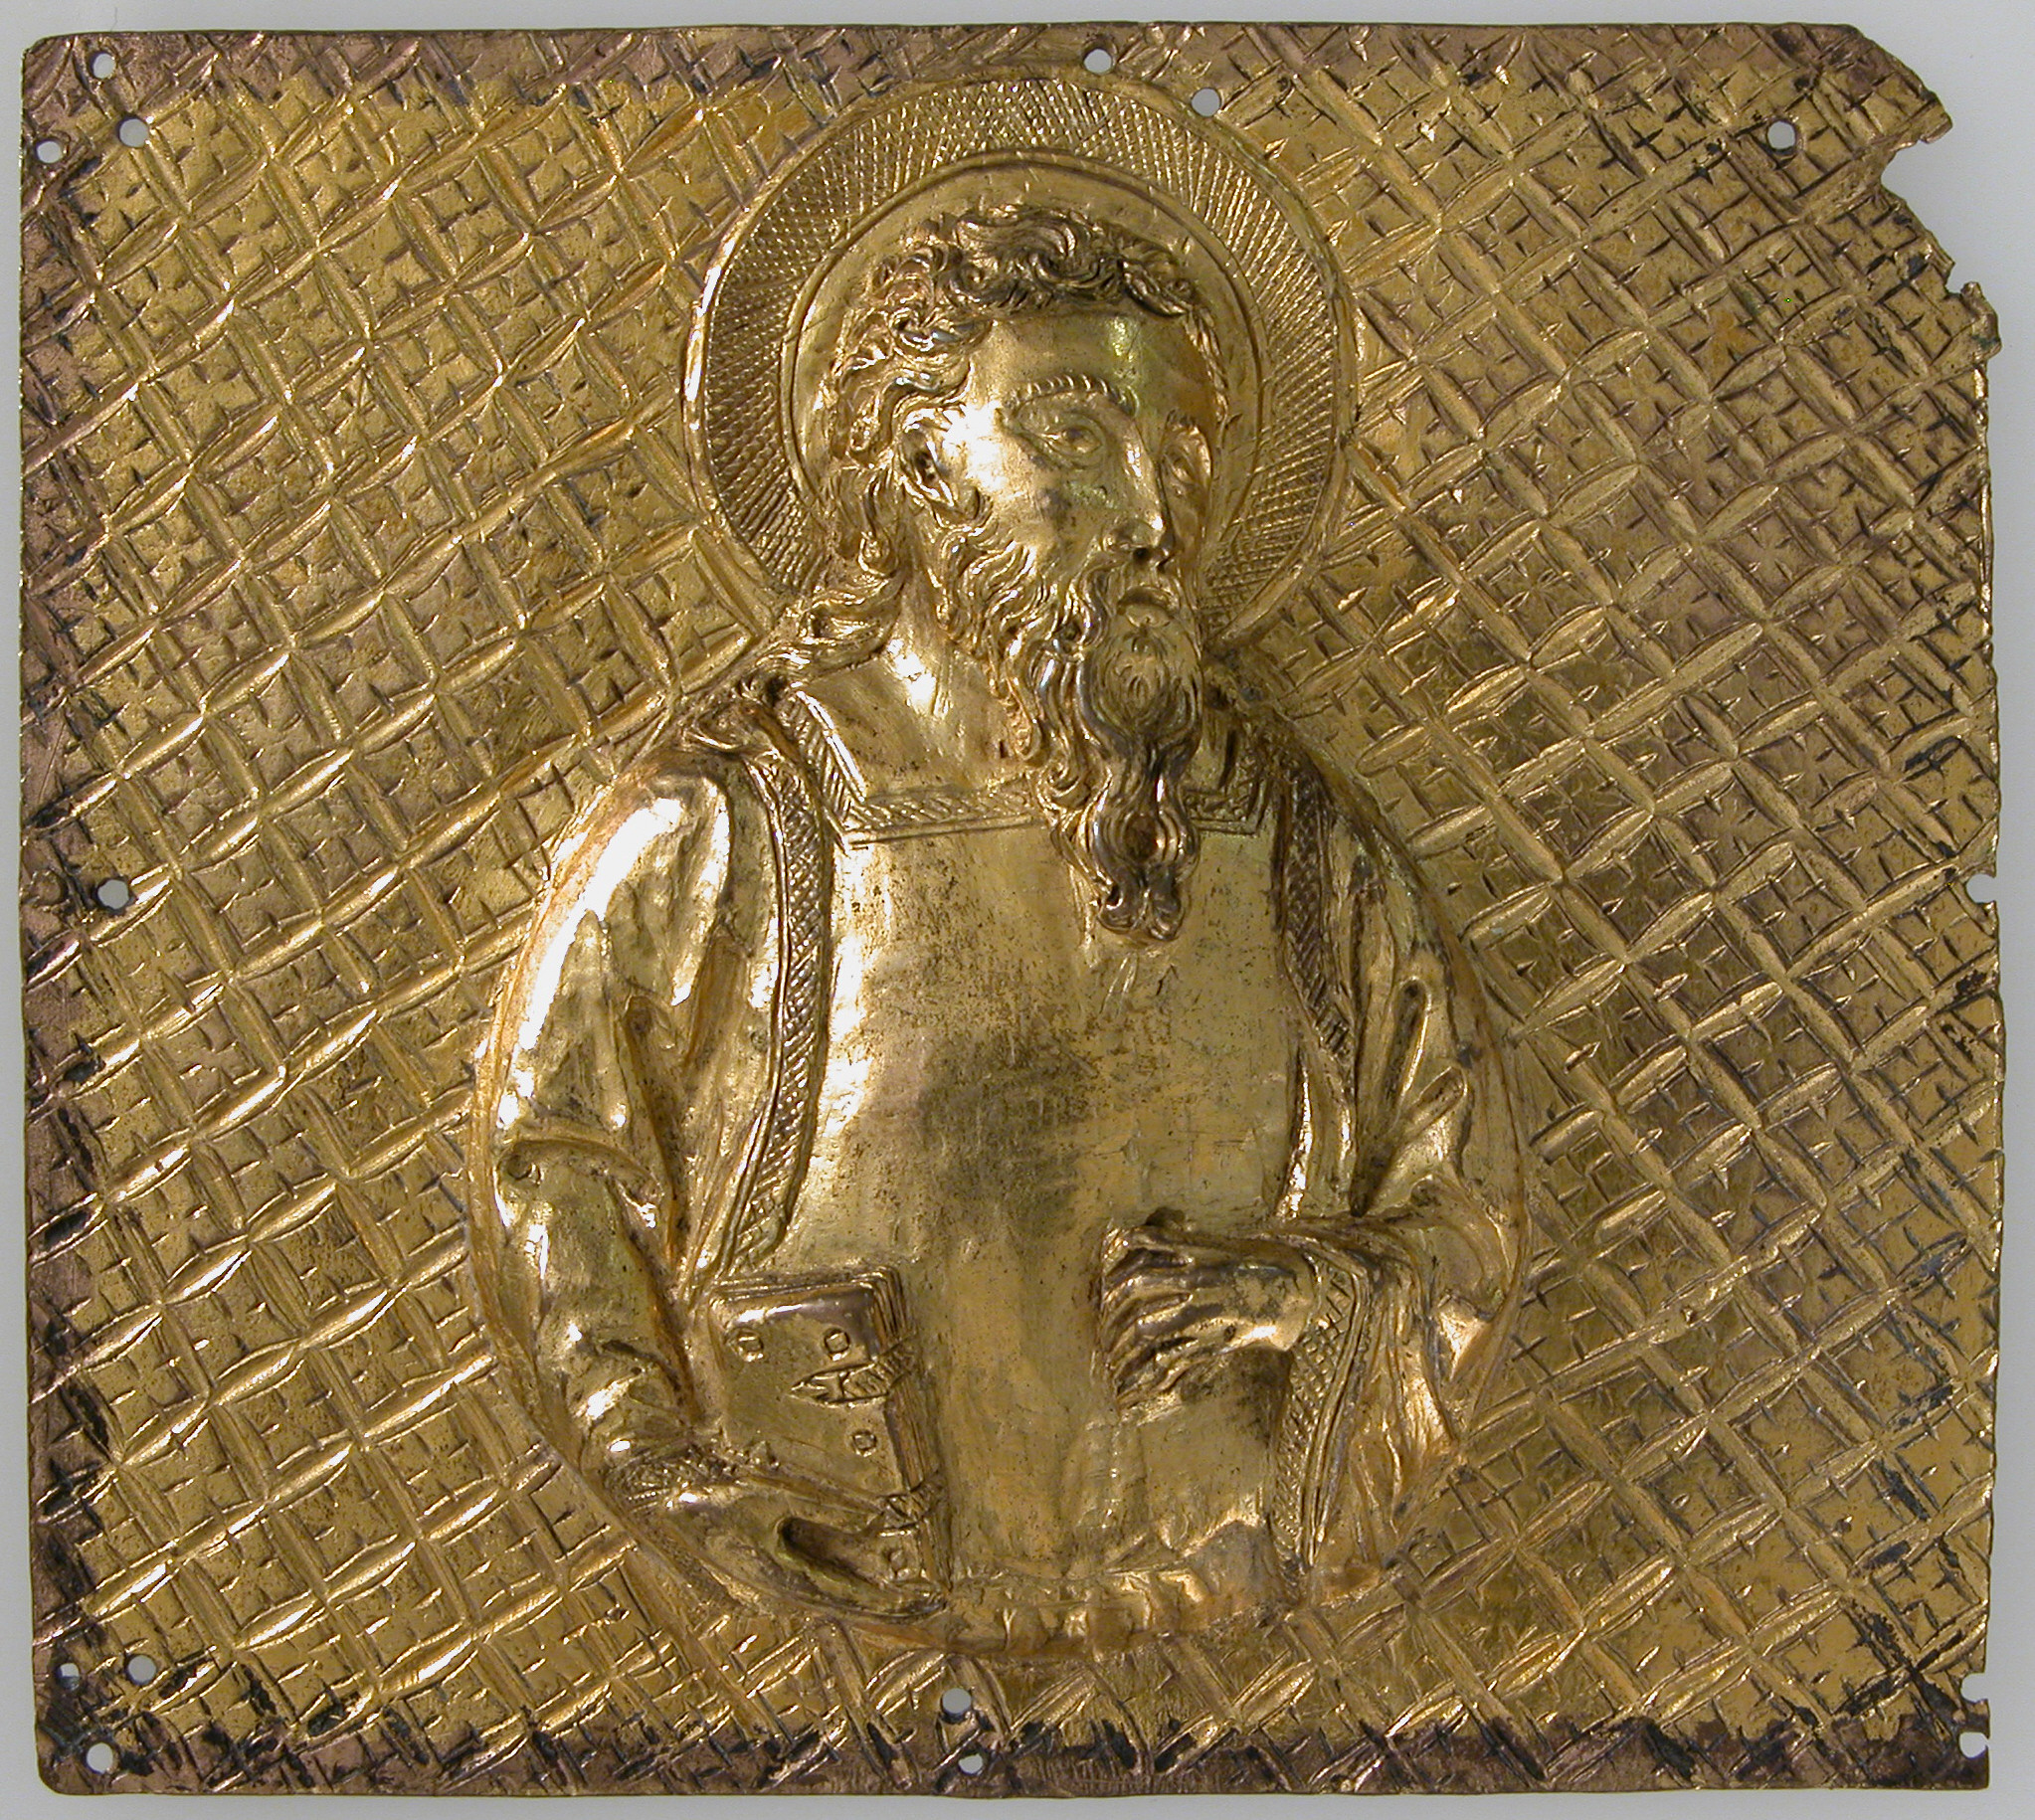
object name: bust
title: Bust of an Apostle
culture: north italian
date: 1401-1433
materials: copper alloy, gilt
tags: apostles